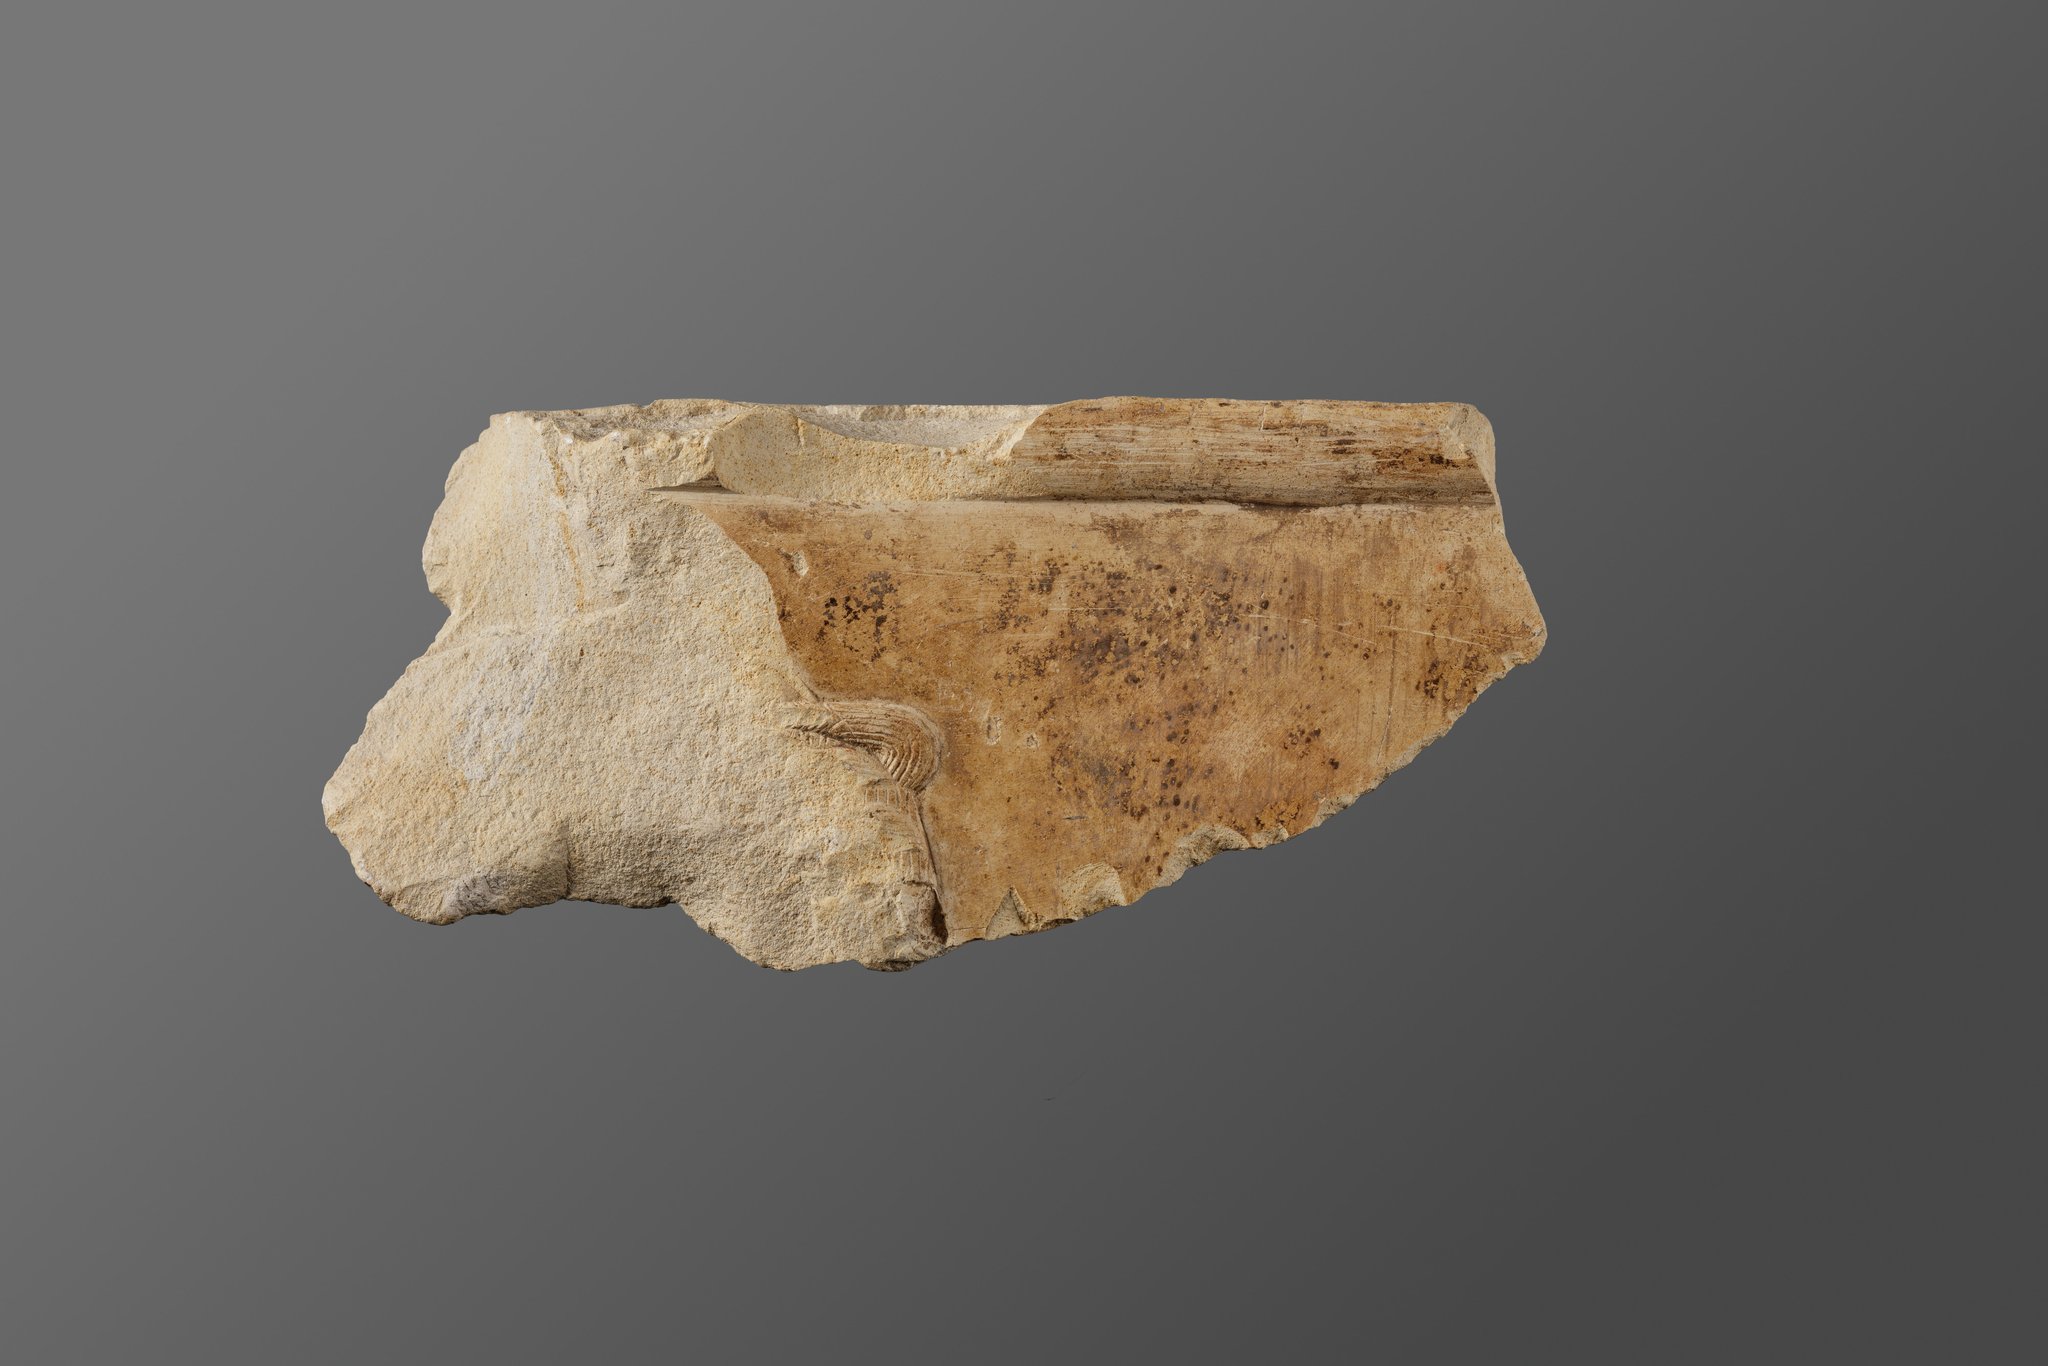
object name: relief fragment, neferu or khety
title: Relief fragment from the tomb of Neferu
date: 2051-2030 BCE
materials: limestone, paint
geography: egypt